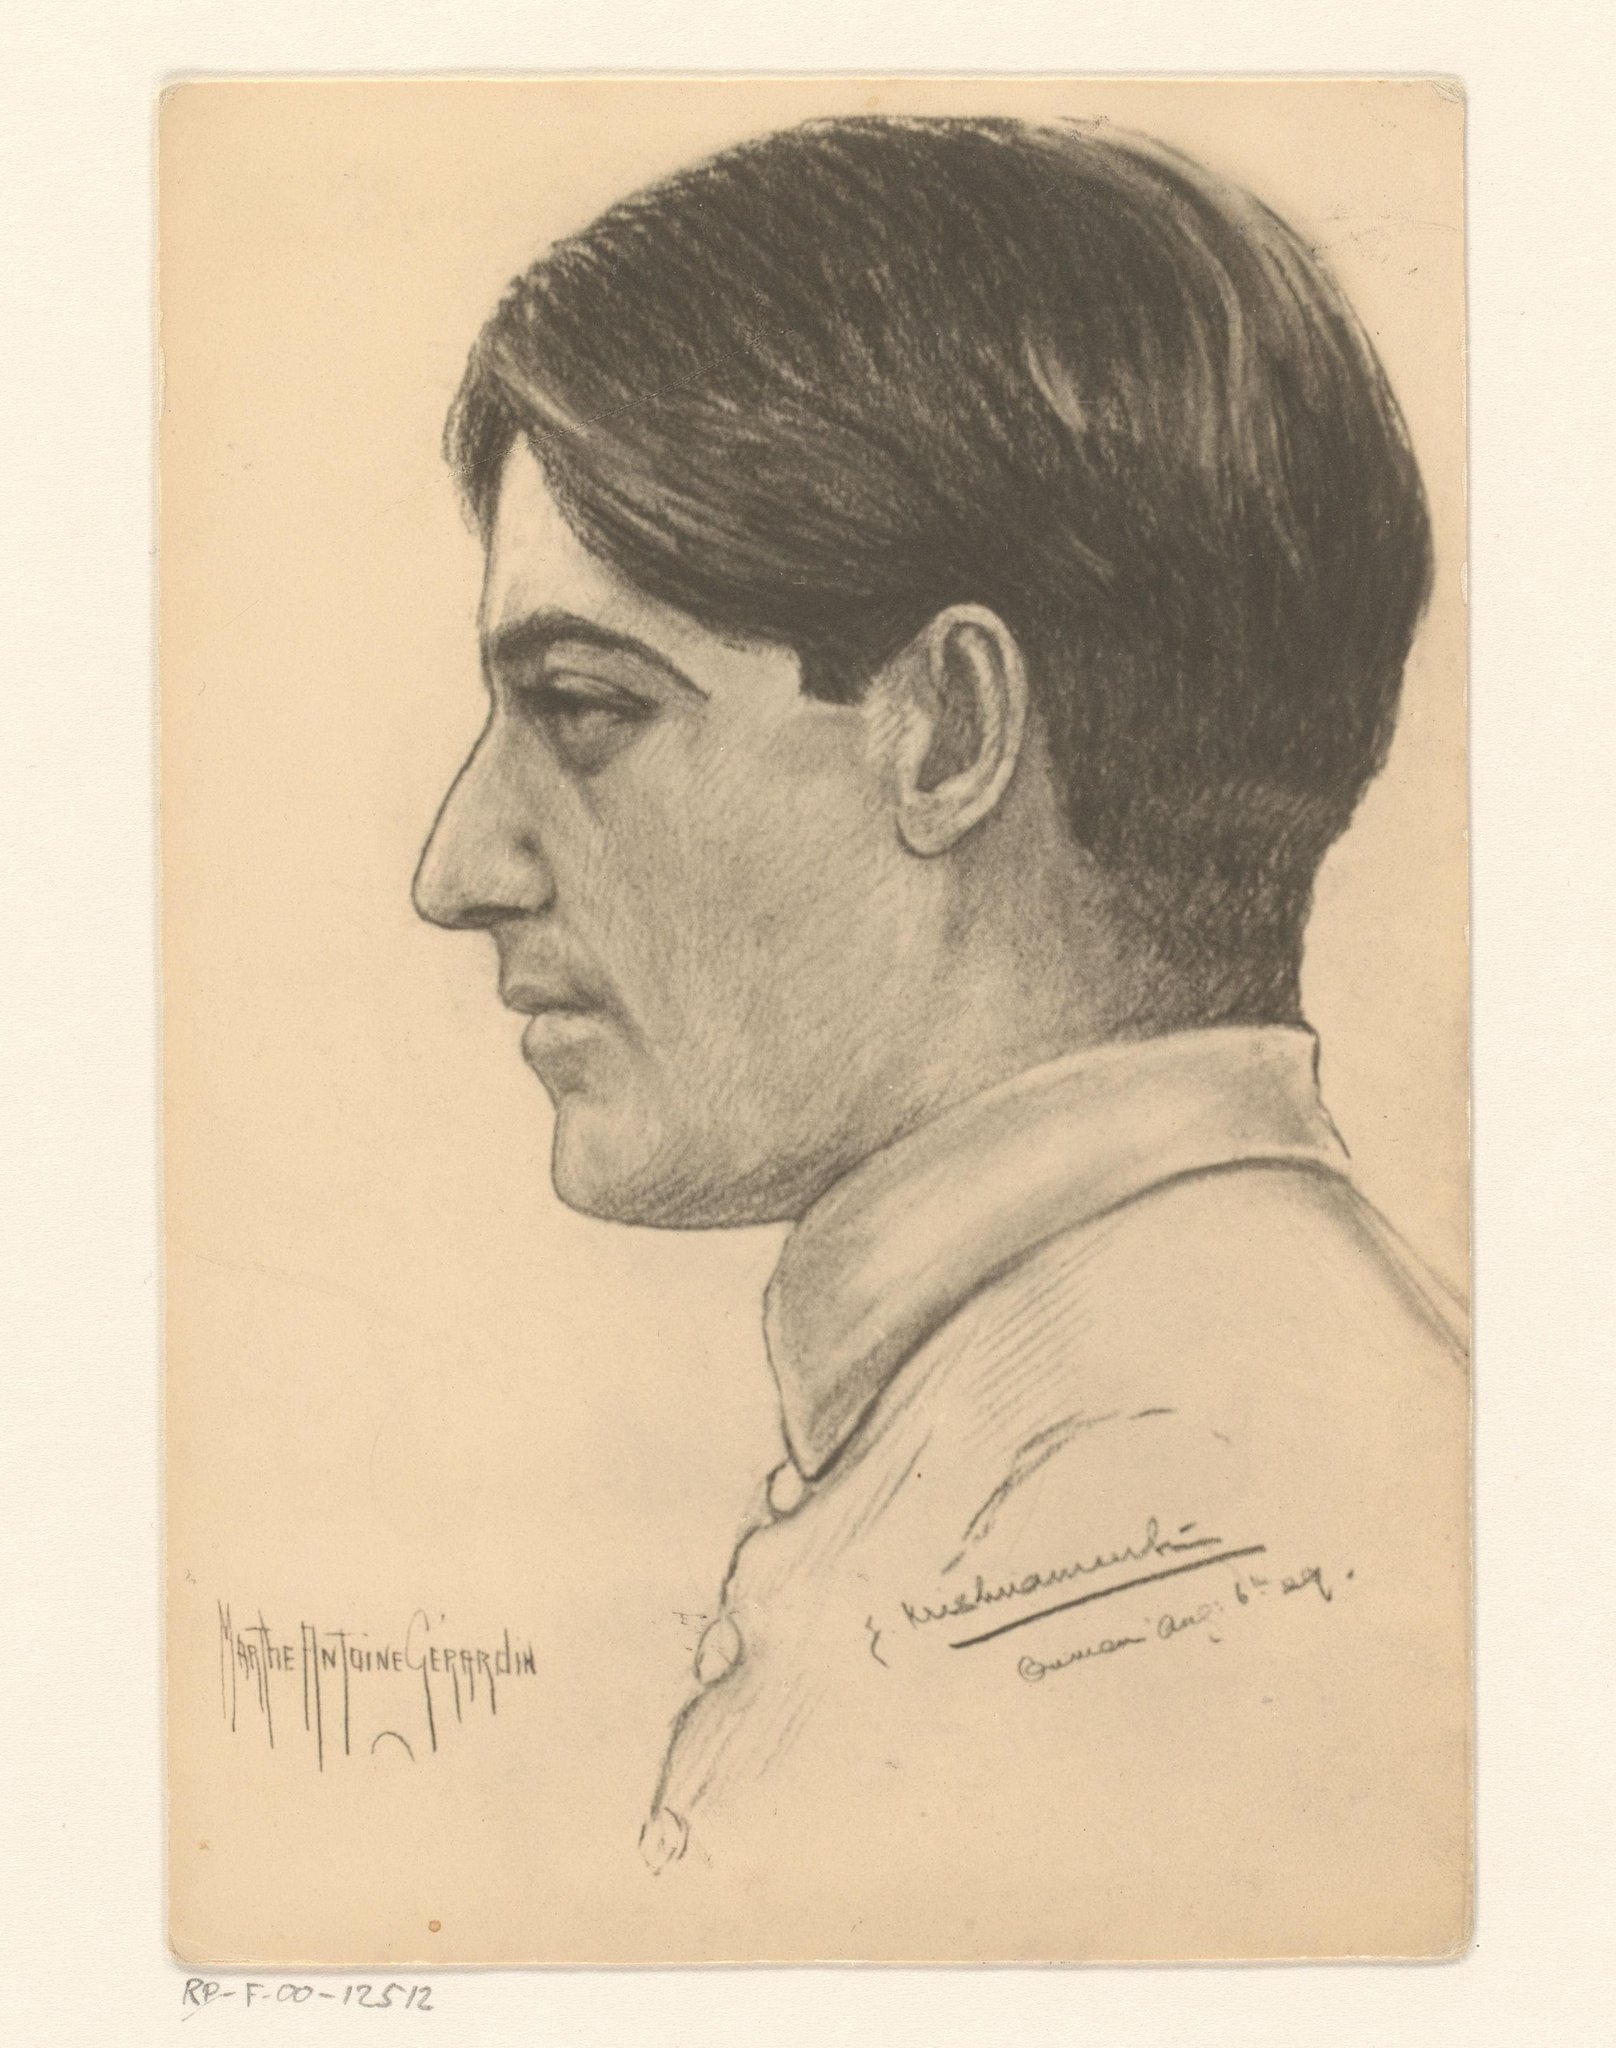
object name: reproduction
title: Fotoreproductie van een getekend portret van Jiddu Krishnamurti, door Marthe Antoine Gérardin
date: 1930-1935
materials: paper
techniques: gelatin silver print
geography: amsterdam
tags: historical persons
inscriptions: address: ‘AMSTERDAM.../ Weteringschans 78’